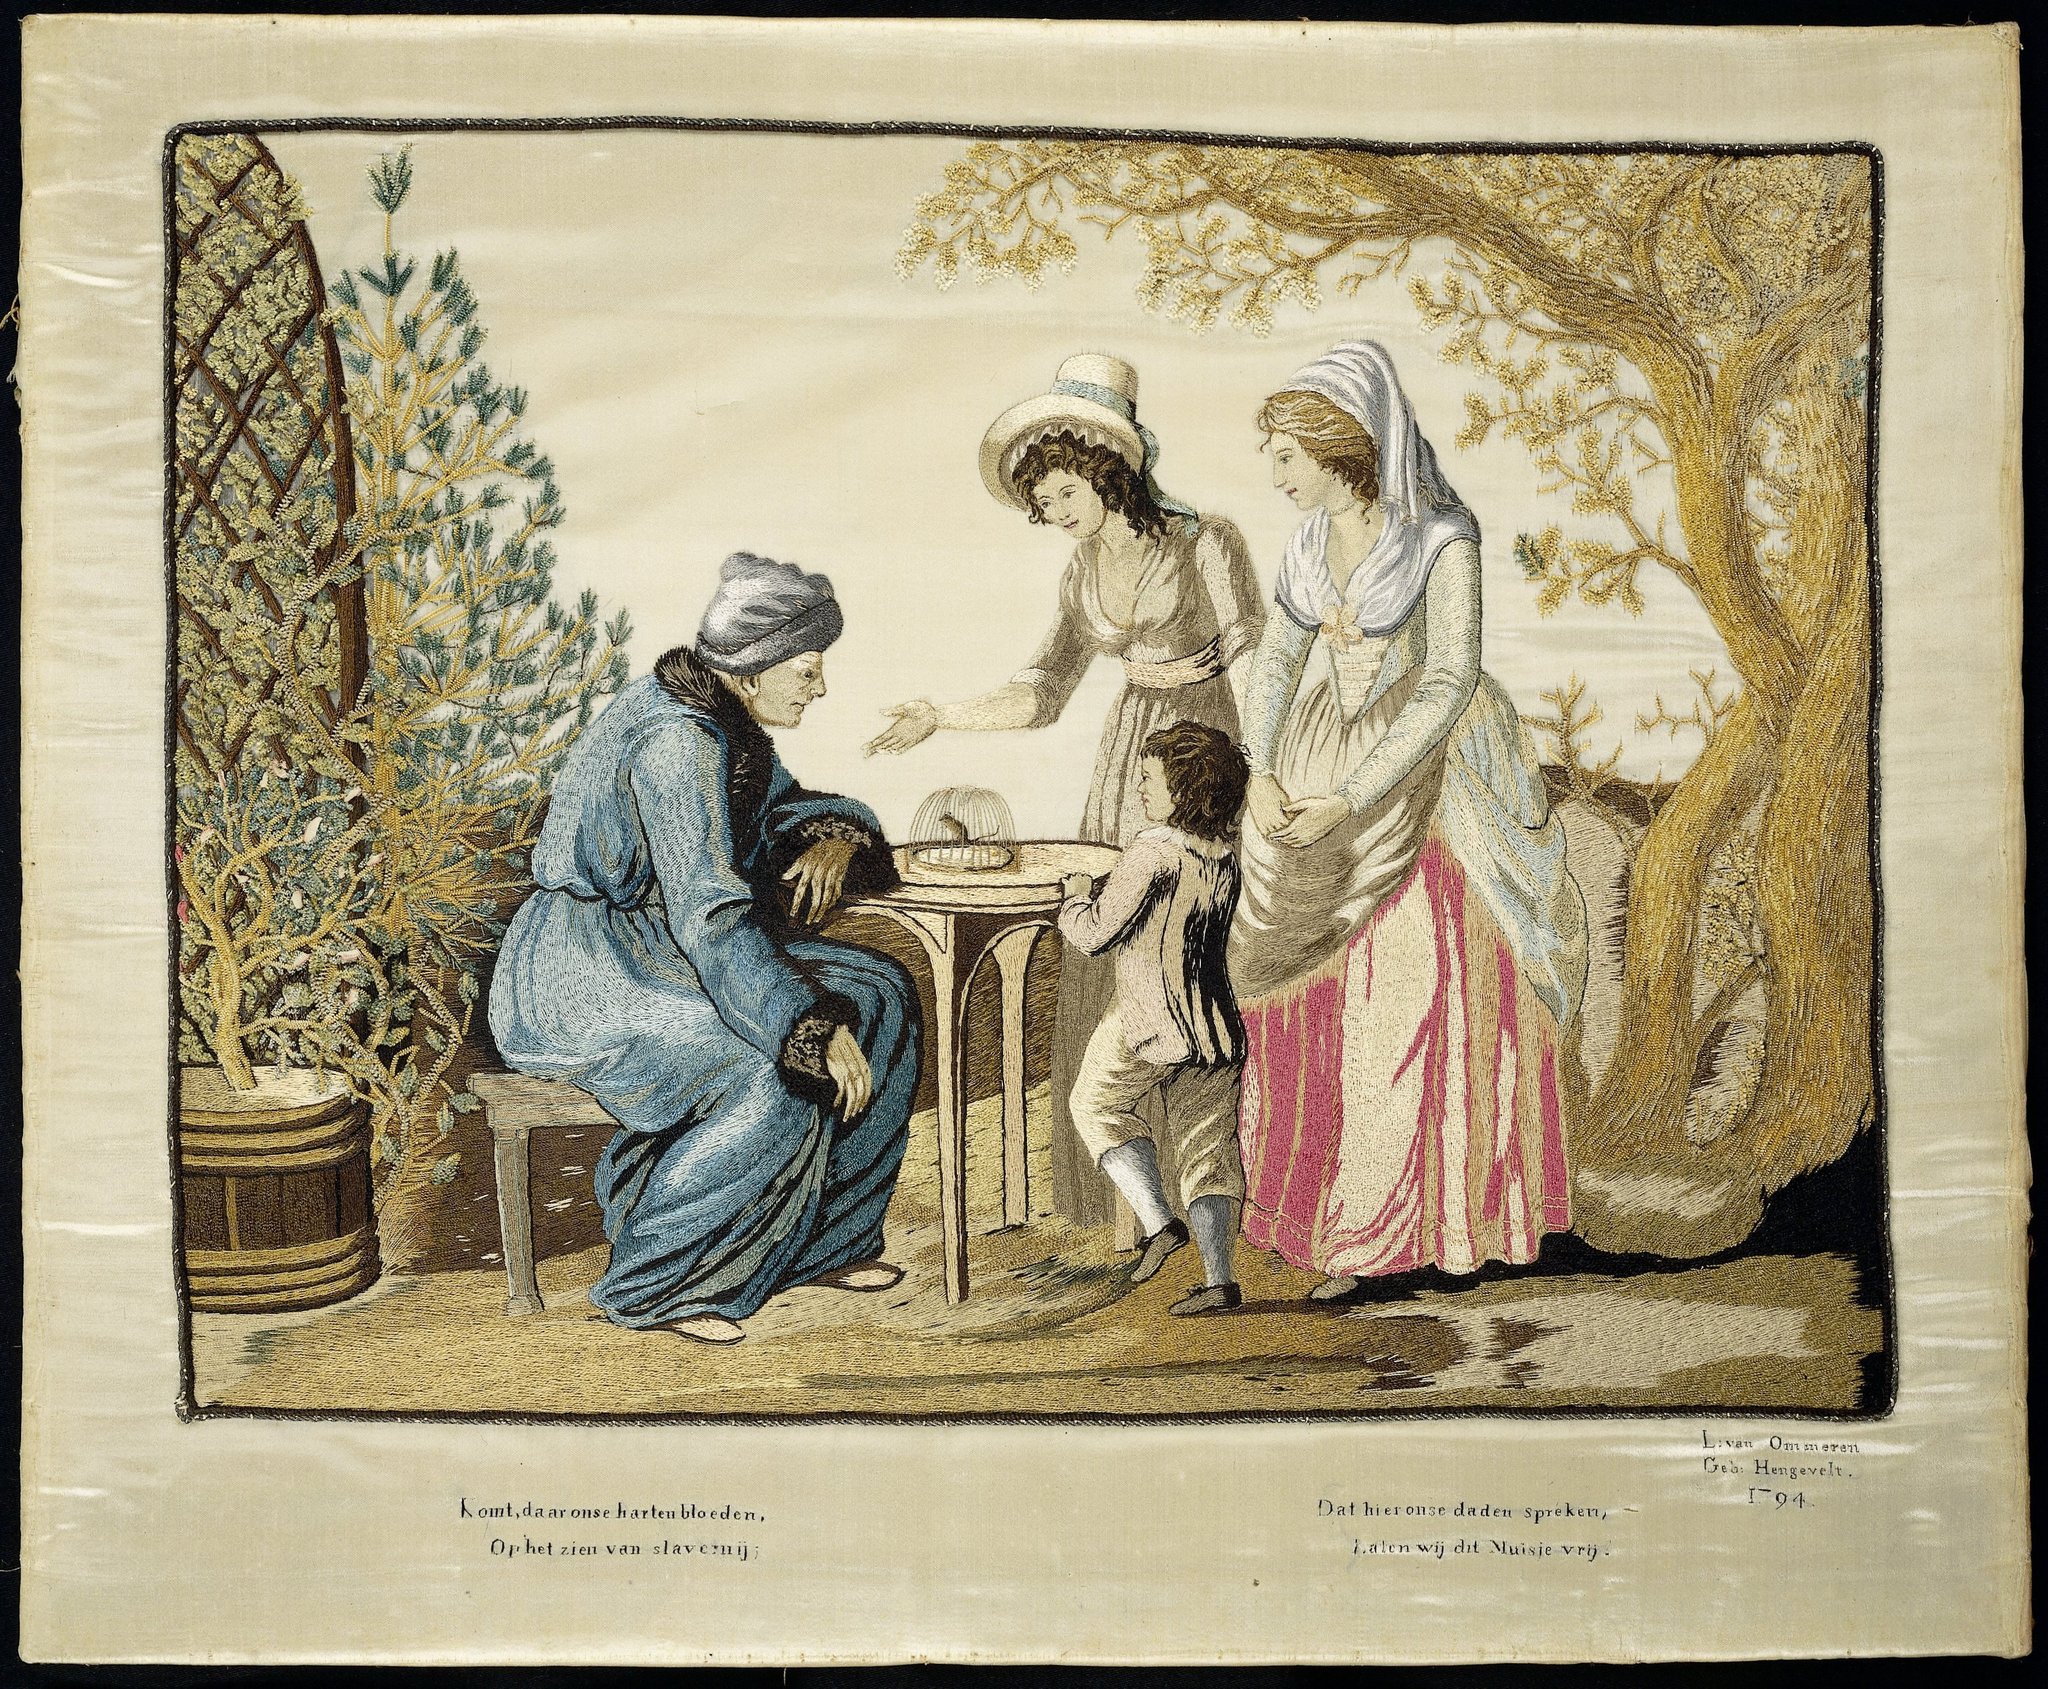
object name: embroidery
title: Patriotse visie op slavernij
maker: louise van ommeren-hengevelt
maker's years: 1757-1846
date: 1794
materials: silk, wood, yarns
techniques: embroidered, gilding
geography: arnhem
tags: liberation (of an enslaved person), abolition of slavery, fighting slavery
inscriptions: signature and date: ‘L. van Ommeren / Geb. Hengevelt / 1794’, inscription: ‘Komt, daar onse harten bloeden / Dat hier onse daden spreken, / Op het zien van slavernij / Laten wij dit Muisje vrij.’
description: Patriots anti-slavernij borduurwerk door L. van Ommeren-Hengevelt, 1794 Aan het eind van de 18de eeuw keerden vooruitstrevende burgers in de Republiek zich tegen de slavernij. Het borduursel bestaat uit een Rijmpje en een voorstelling van een familie in een tuin rond een tafel waarop een muis in een muizenval.